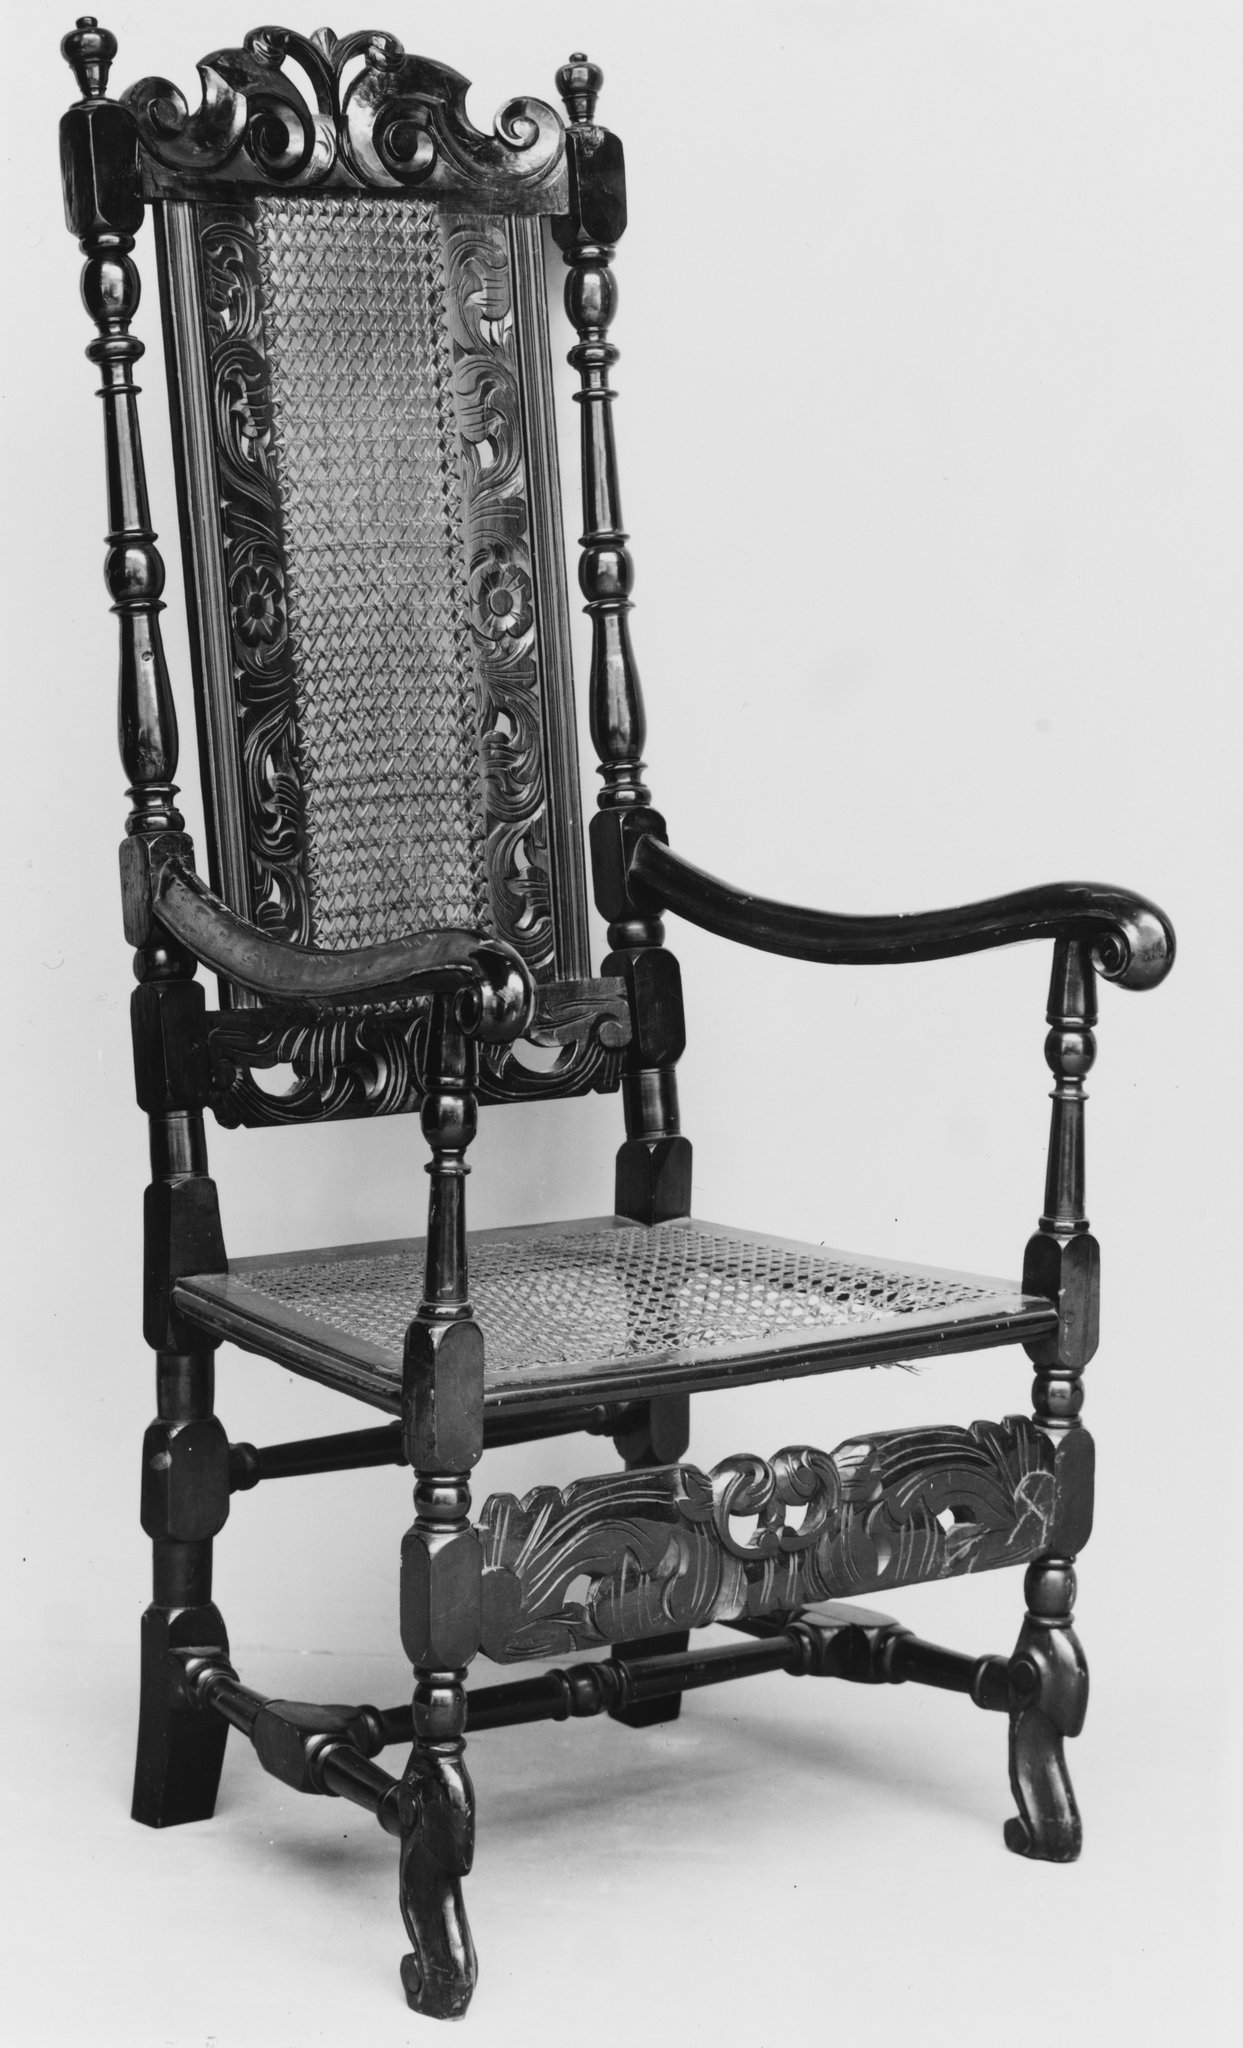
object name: armchair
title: Cane armchair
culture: british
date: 1690-1710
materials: wood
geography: england